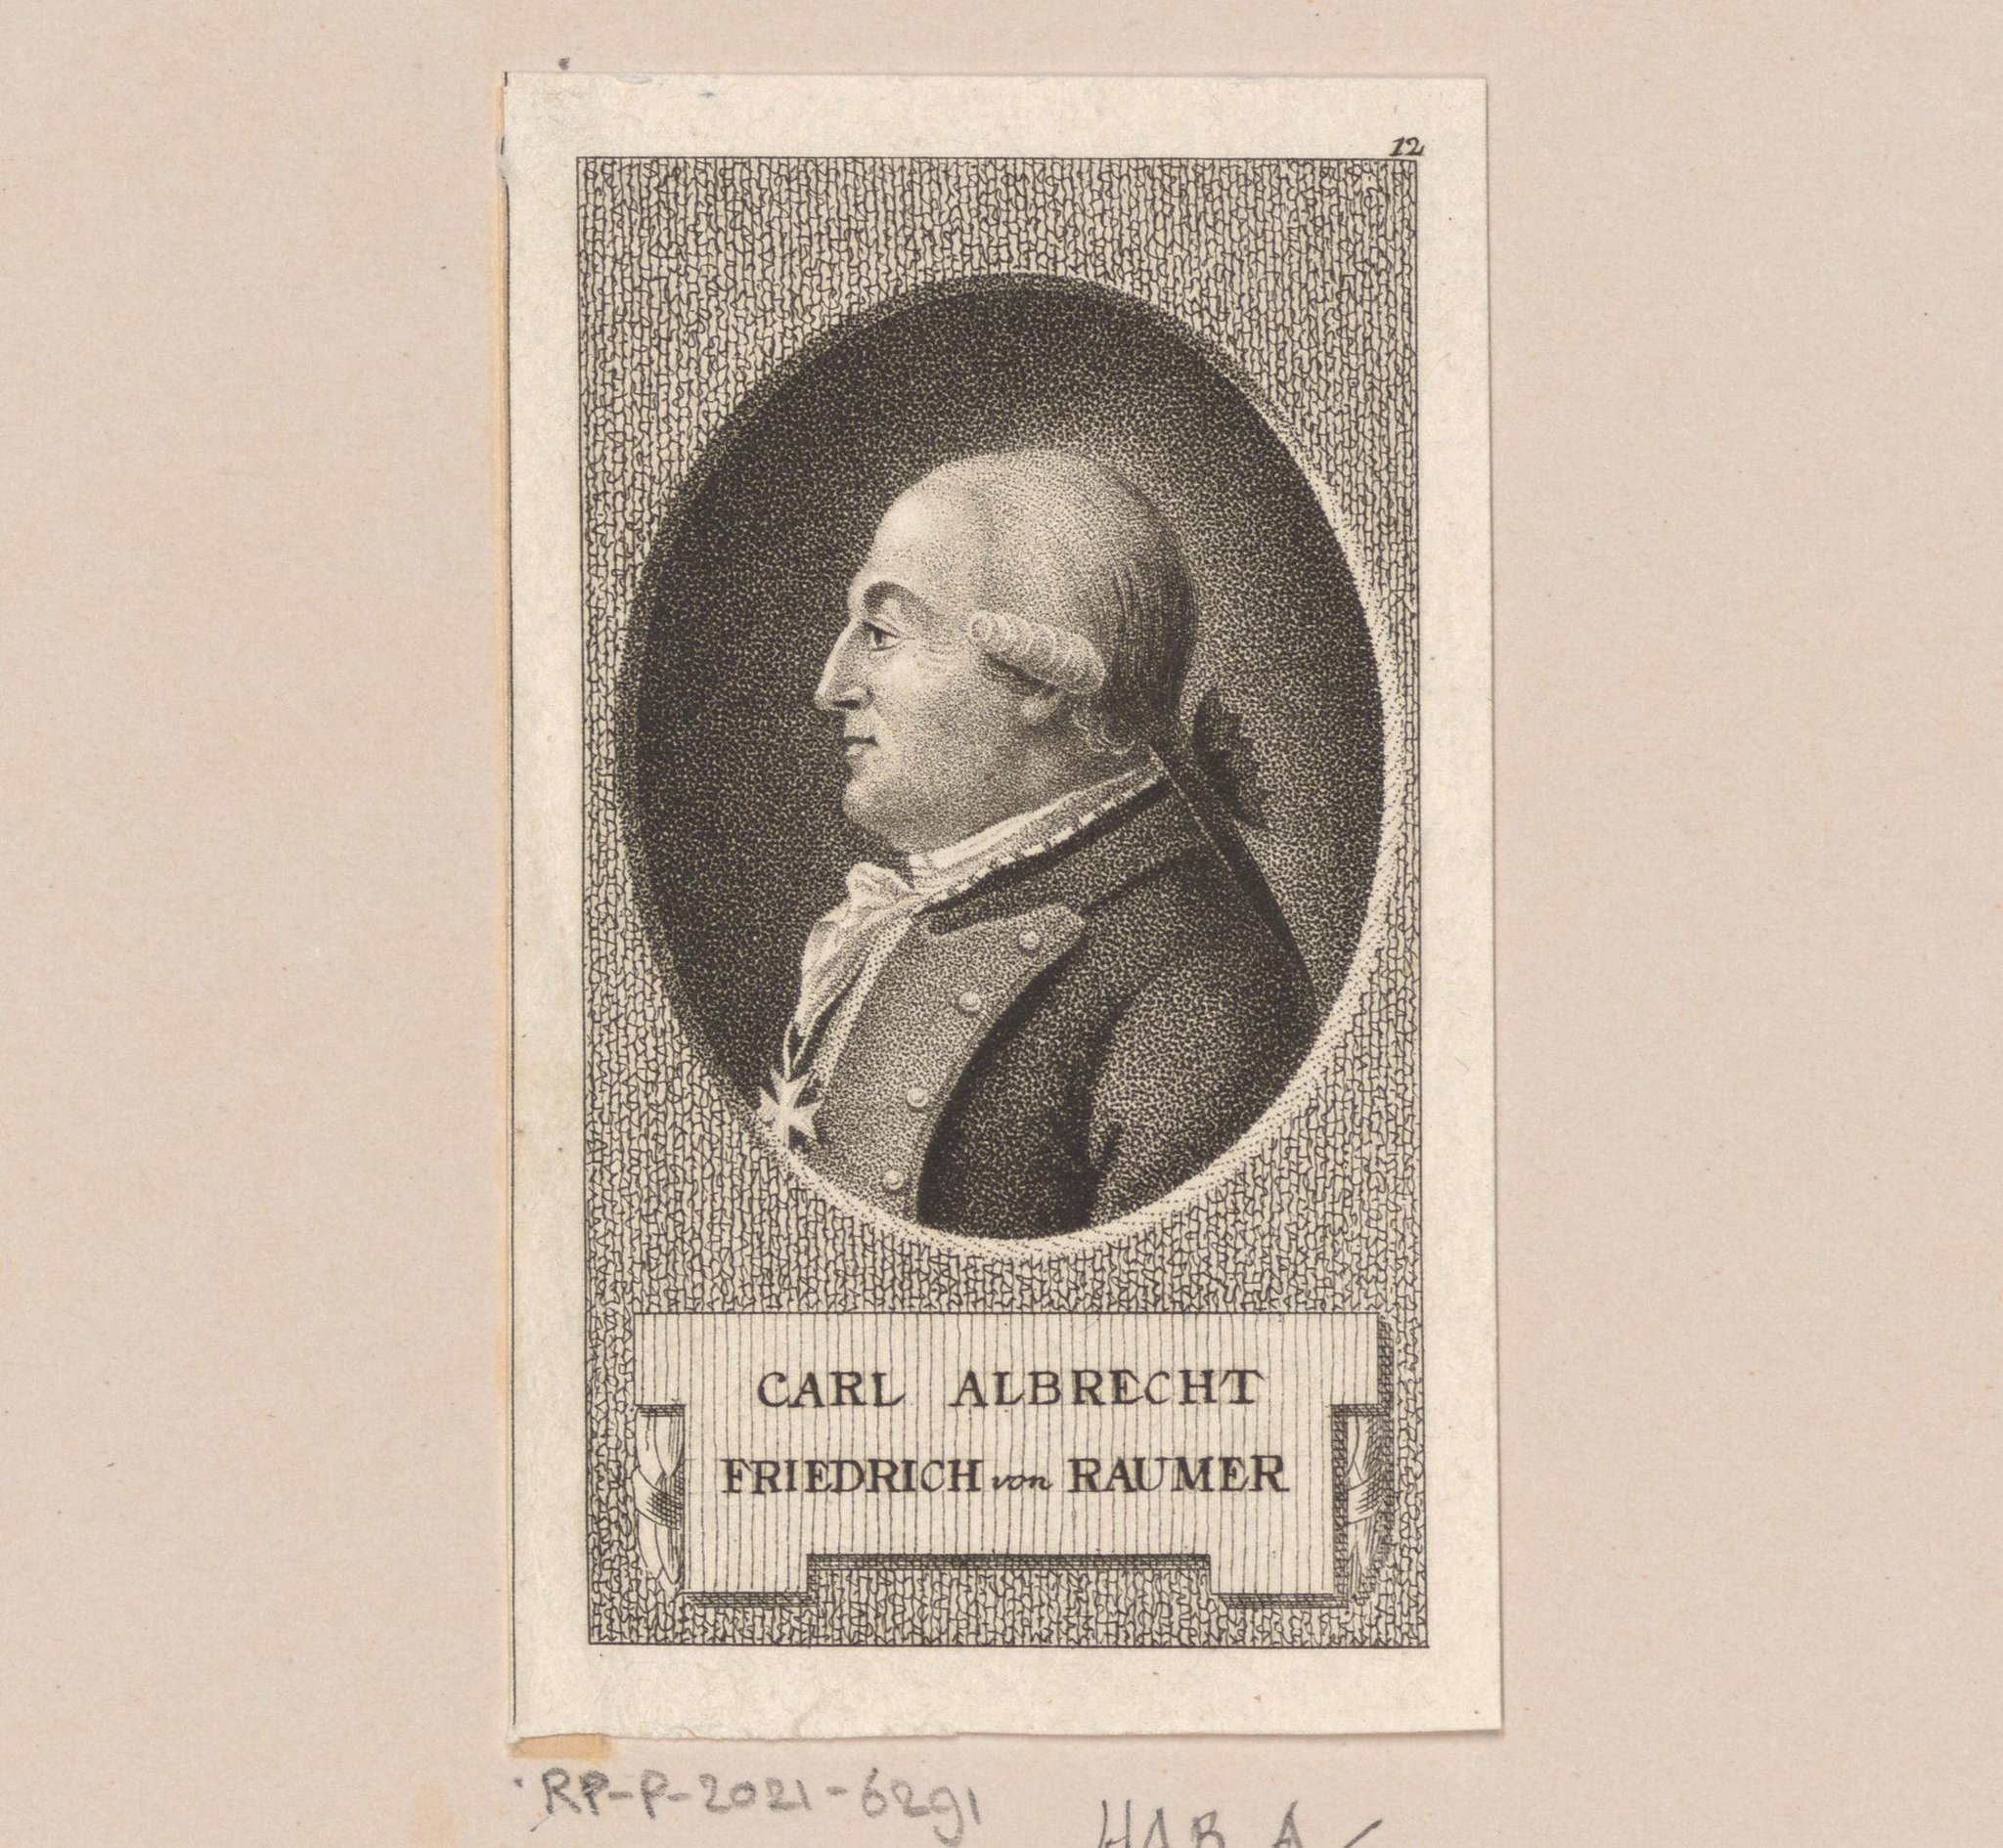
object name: print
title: Portret van Karl Albrecht Friedrich von Raumer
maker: daniel berger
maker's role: print maker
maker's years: 1744-1824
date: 1764-1824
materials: paper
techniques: engraving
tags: historical persons